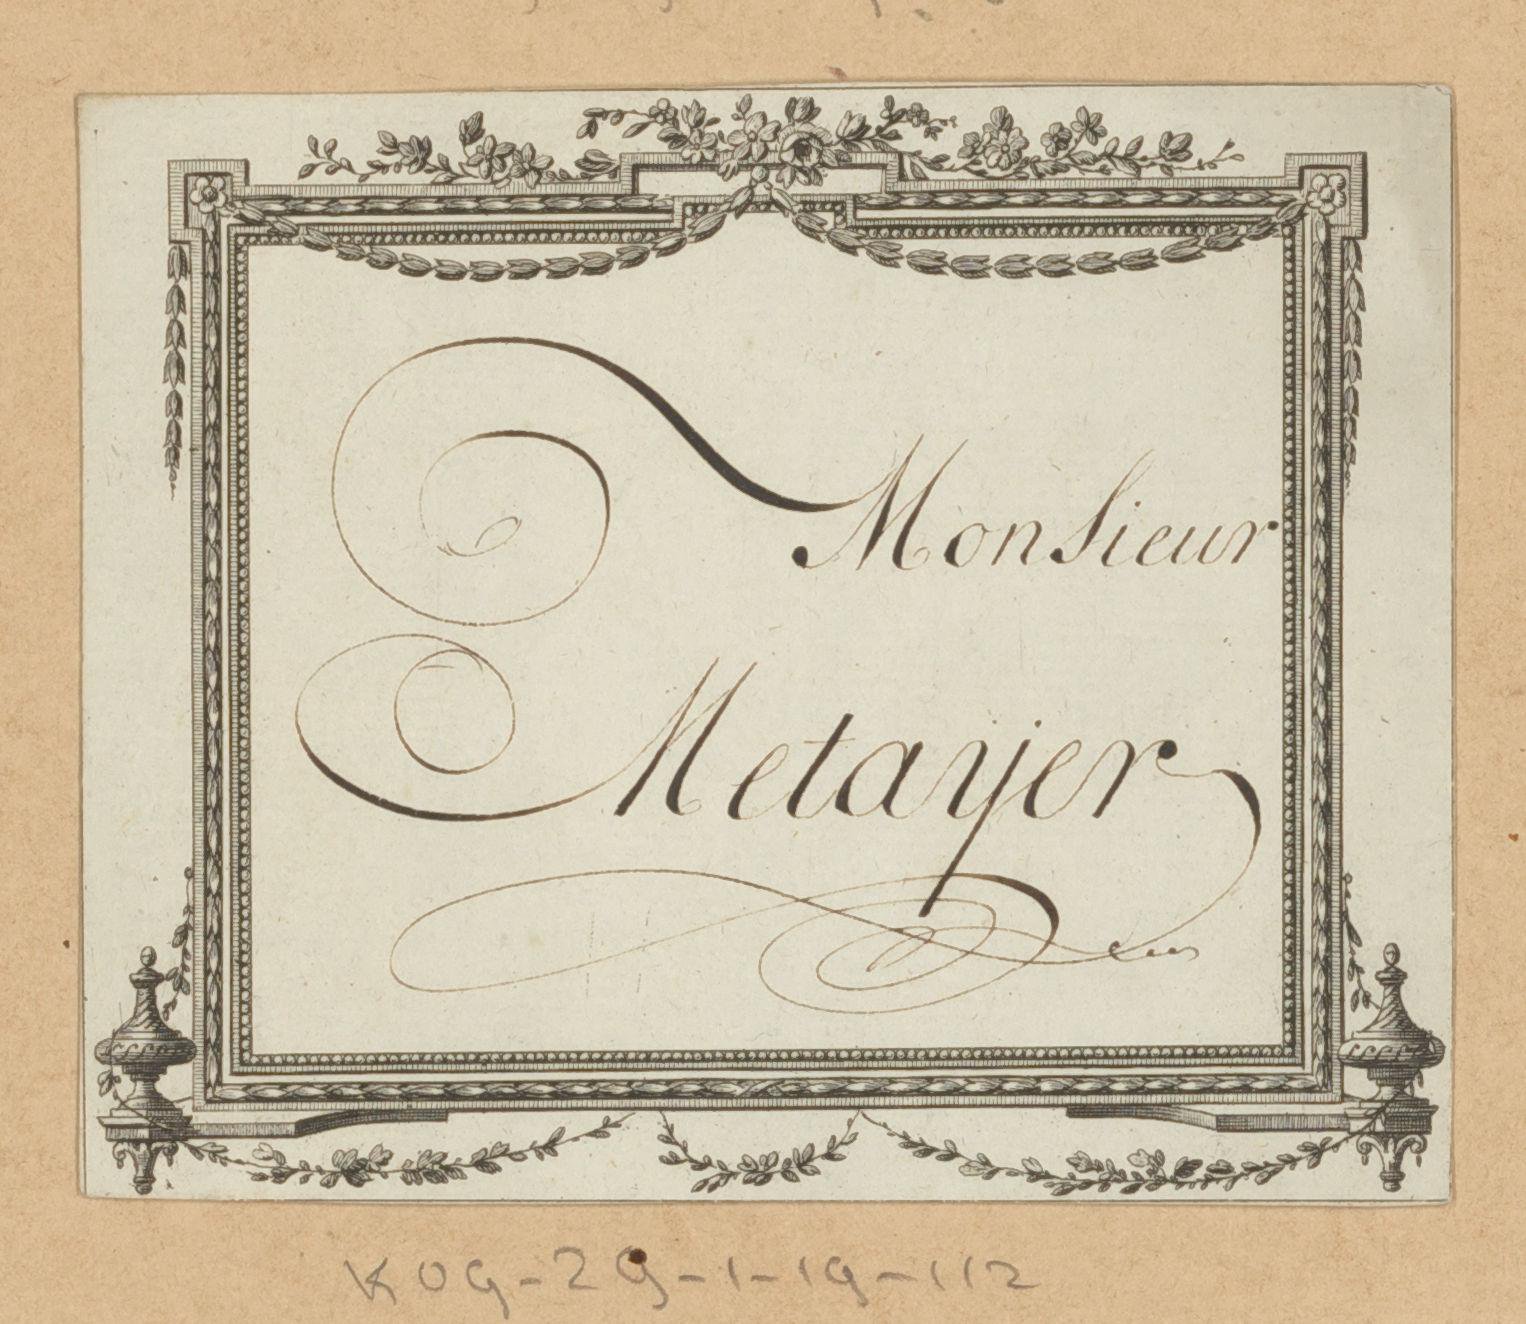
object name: print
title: Bruiloftskaart voor 'Monsieur Metayer'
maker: Anonymous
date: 1790-1799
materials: paper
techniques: engraving, etching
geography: netherlands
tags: goldsmith, louis metayer phzn., wedding feast, wedding meal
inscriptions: collector's mark: Lugt 1641, collector's mark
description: Naamkaartje voor de heer Louis Metayer, te gebruiken bij de tafelindeling bij een bruiloftsmaal. Onderdeel van een groep van bruilofts- en invitatiekaartjes van de families Bernard en Metayer. Onderwerpsrubrieken binnen de Atlas Zeden en Gewoonten: Des Menschen Begin, Midden en Einde. Bruiloft en huwelijk.